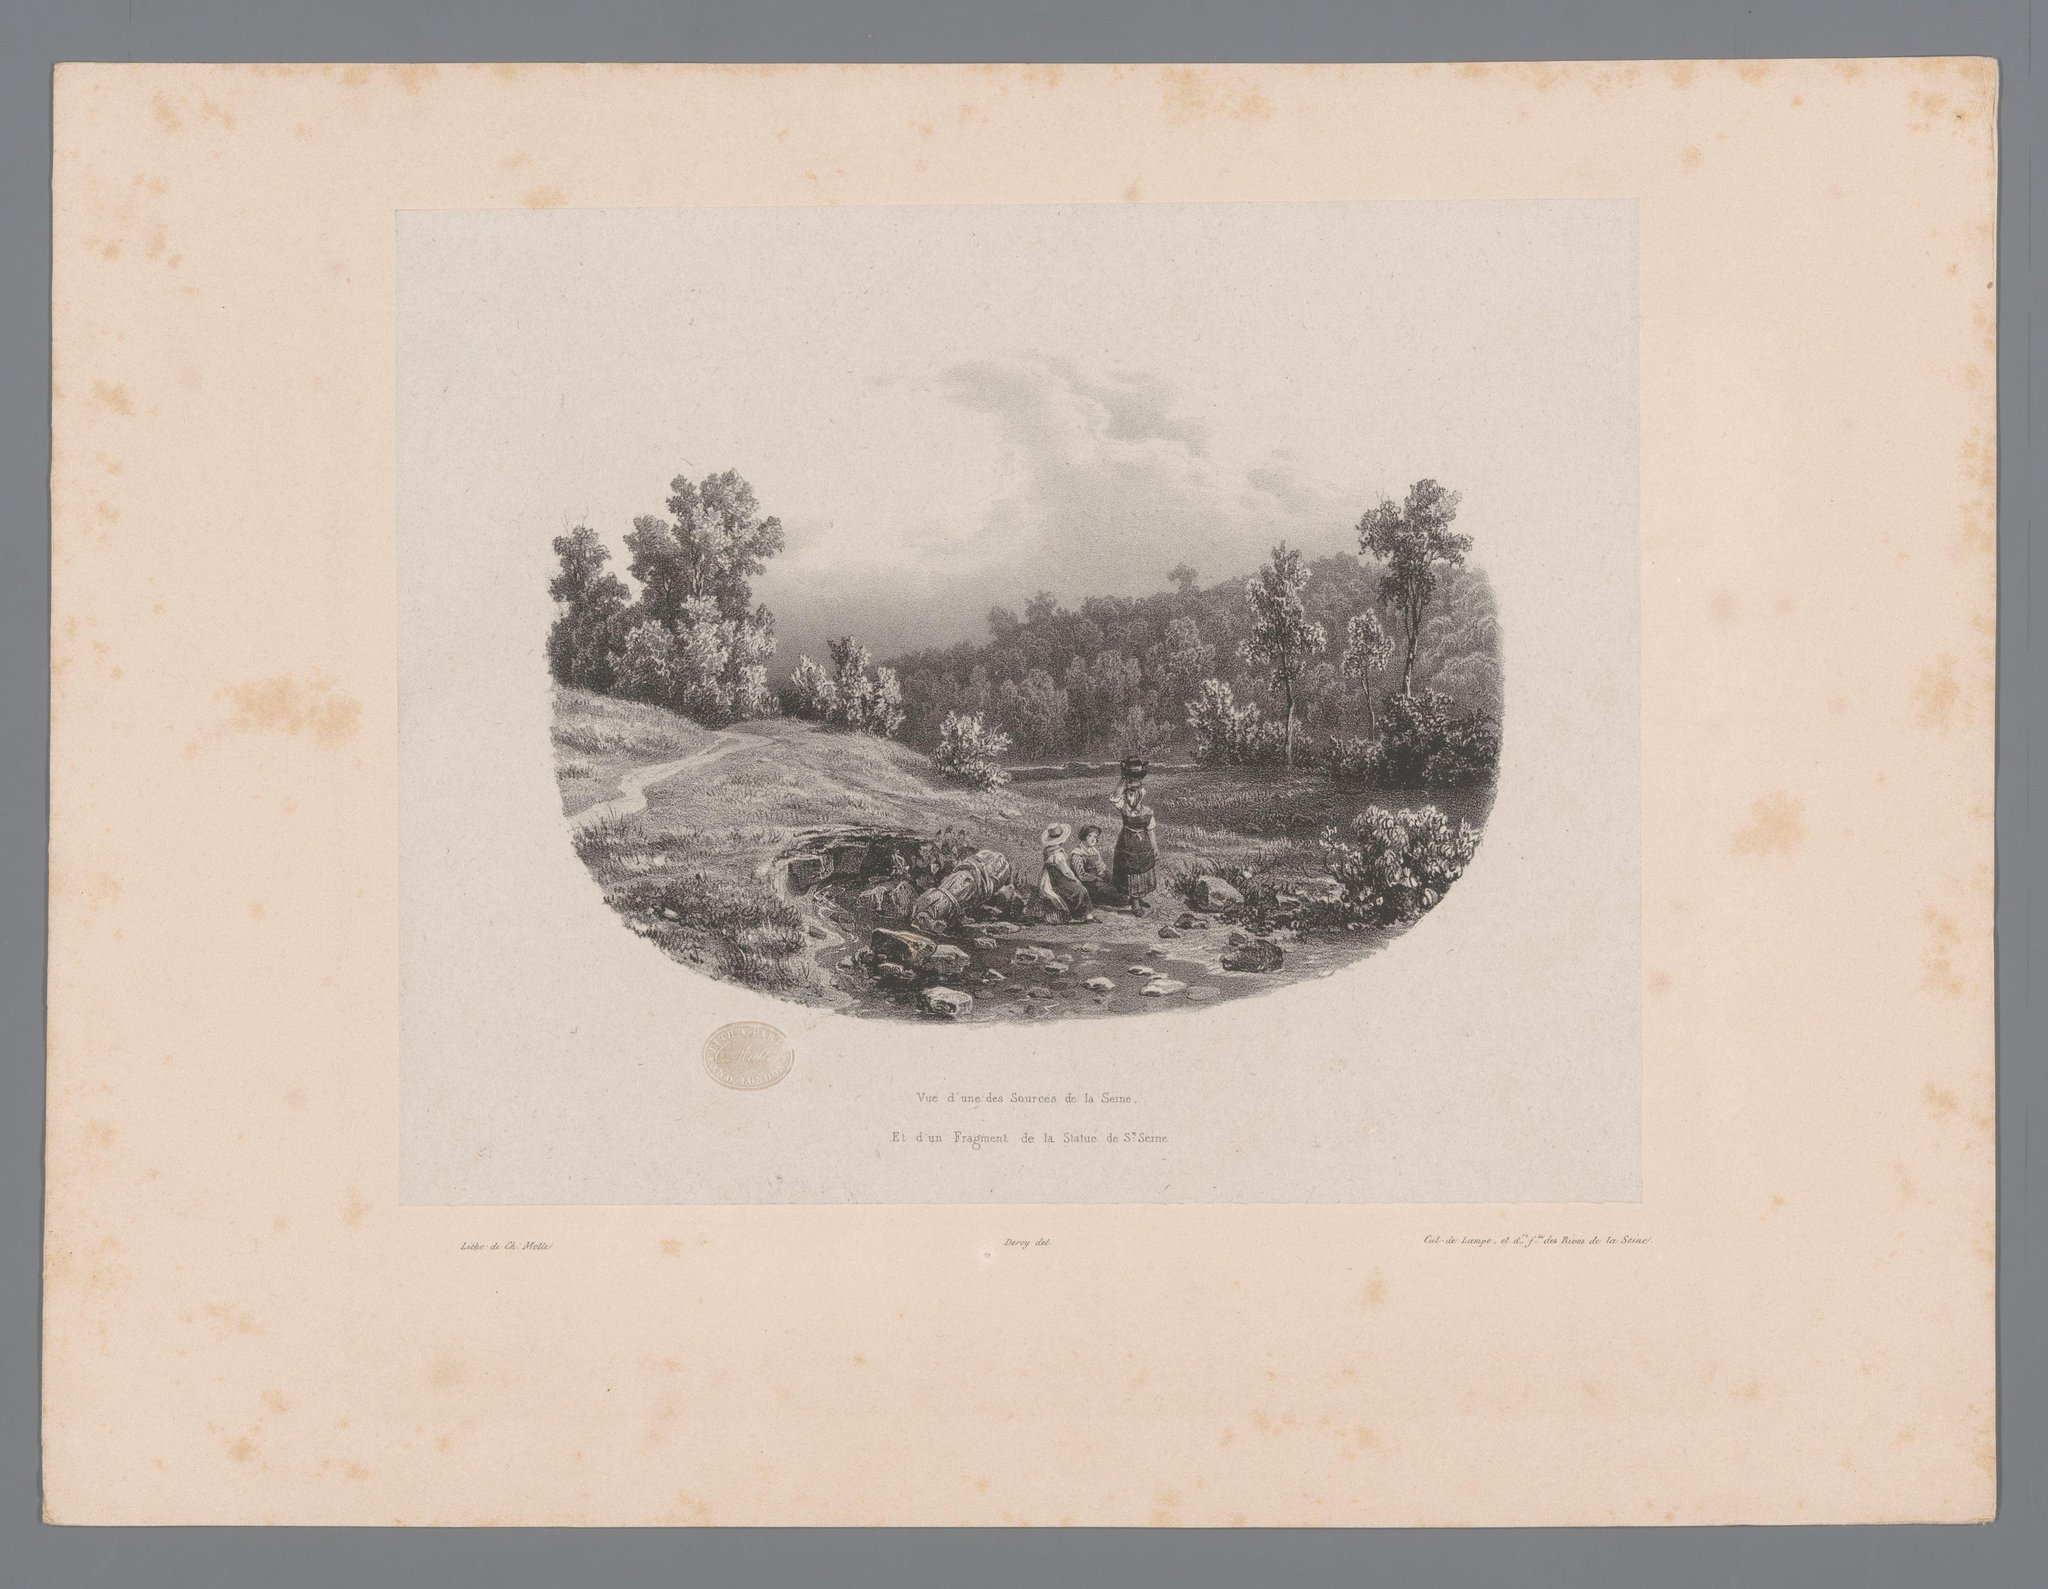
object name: print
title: Les Rives de la Seine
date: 1829-1831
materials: paper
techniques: lithograph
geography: paris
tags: spring, source of river or stream (+ landscape with figures, staffage)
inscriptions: collector's mark: Lugt 2228a, check stamp: Lugt 1828b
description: Prent maakt deel uit van een omslag met veertien prenten.